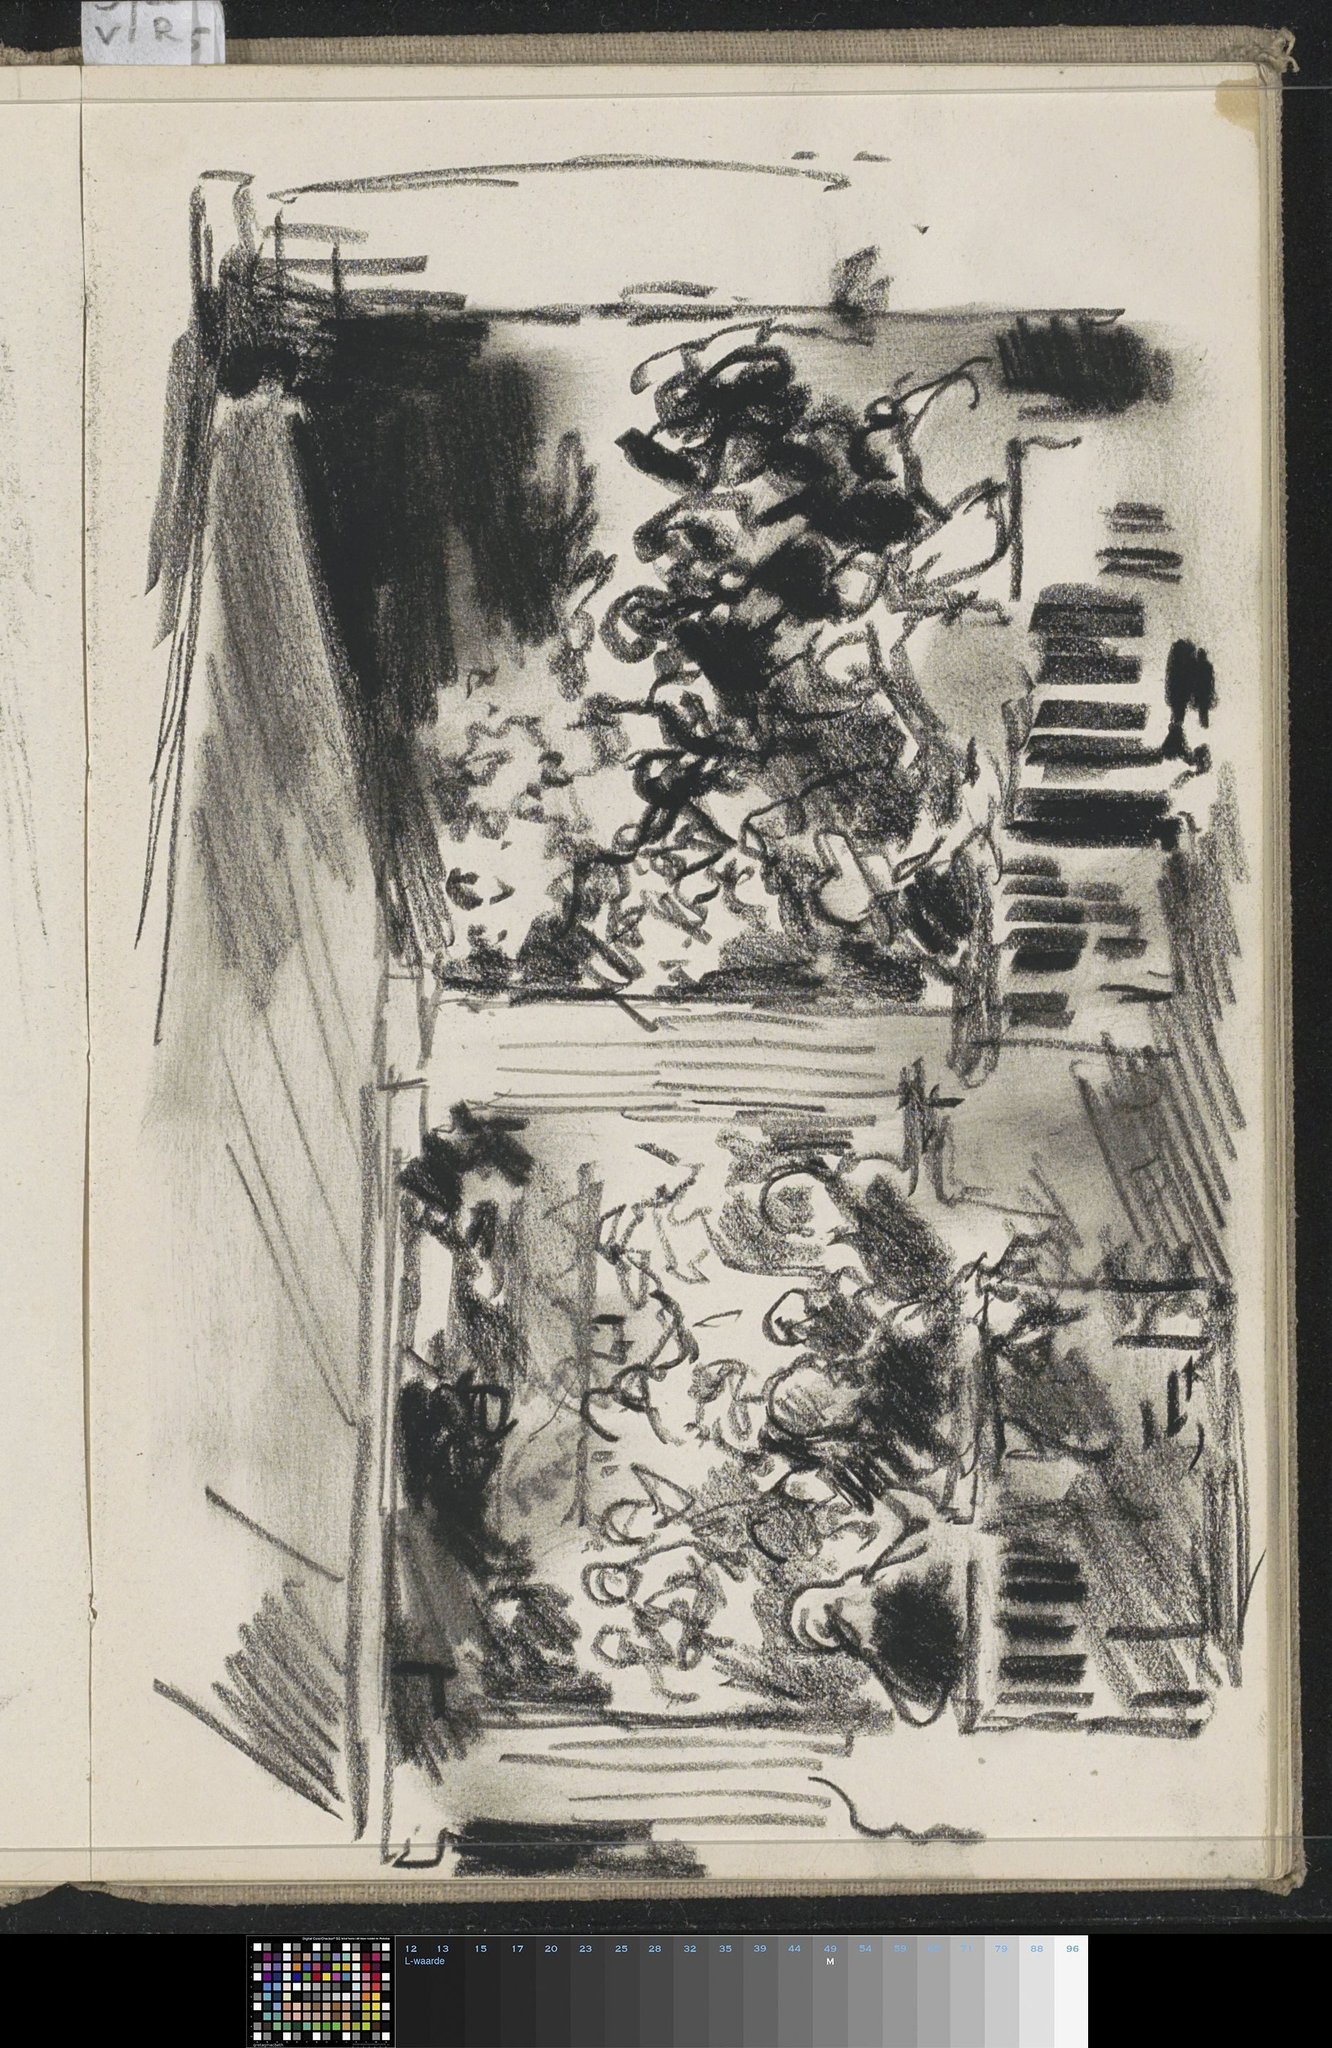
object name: sketchbook leaf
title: Figuren die op een terras naar een mensenmenigte kijken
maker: cornelis vreedenburgh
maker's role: draughtsman, print maker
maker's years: 1880-1946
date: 1890-1946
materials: chalk, paper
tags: pavement, terrace in front of inn or restaurant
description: De figuren zitten onder een door drie zuilen gedragen overkapping. Mogelijk kijken zij naar een voorstelling. Blad 16 recto uit een schetsboek met 41 bladen.